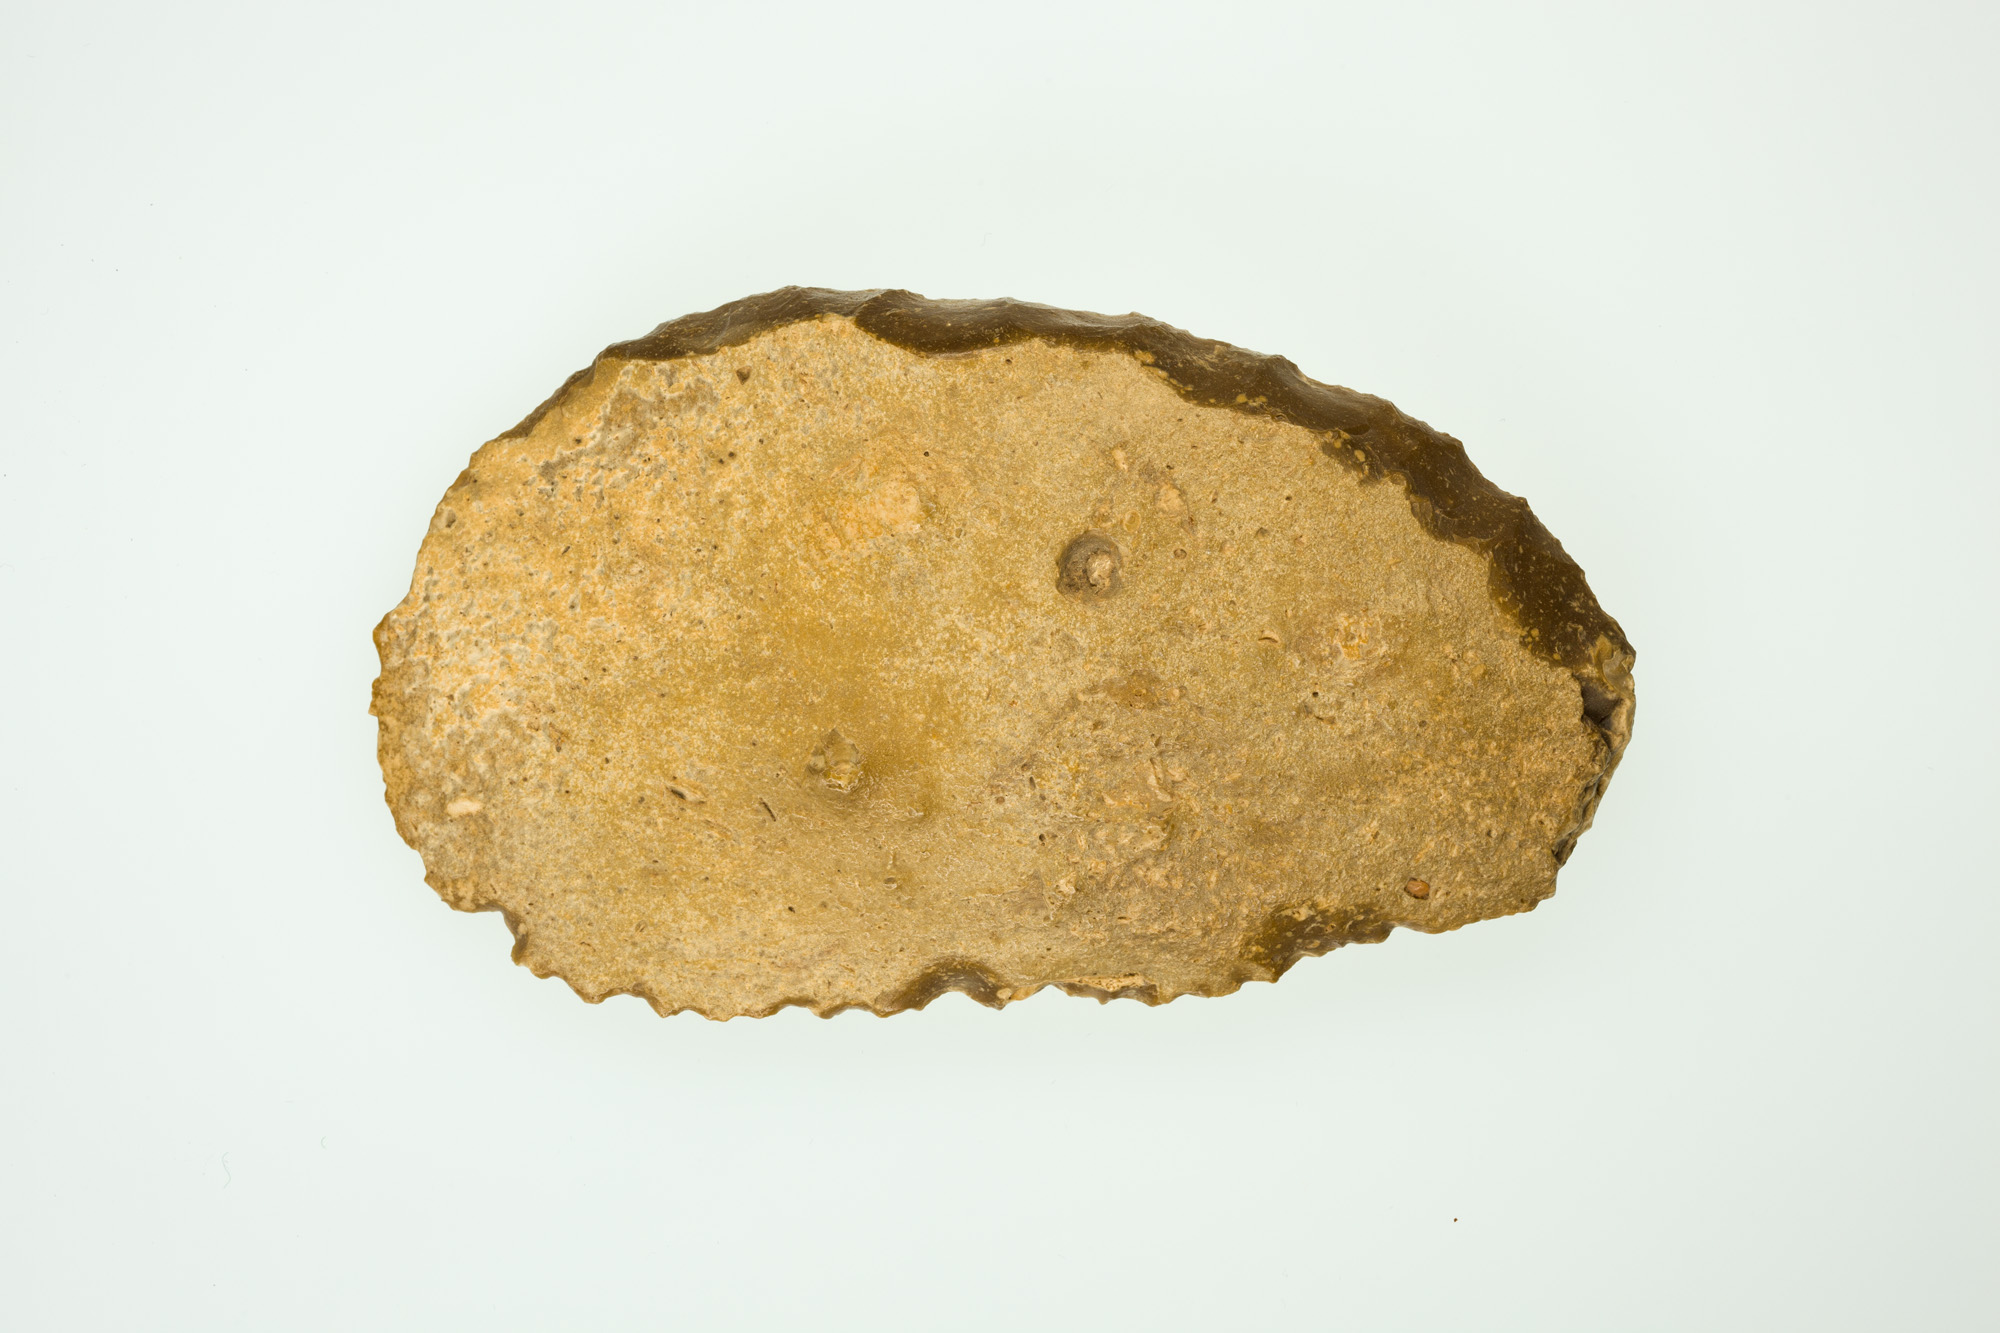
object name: scraper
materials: stone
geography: egypt